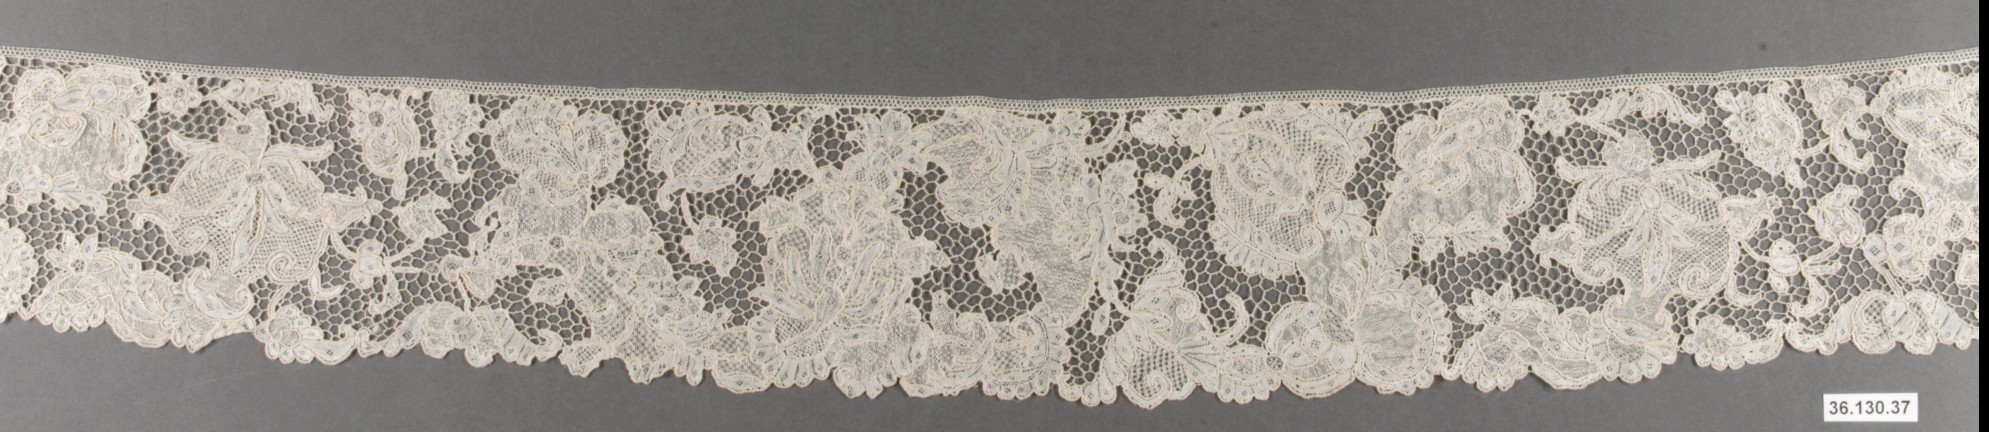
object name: border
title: Borders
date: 1701-1733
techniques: lace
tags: flowers